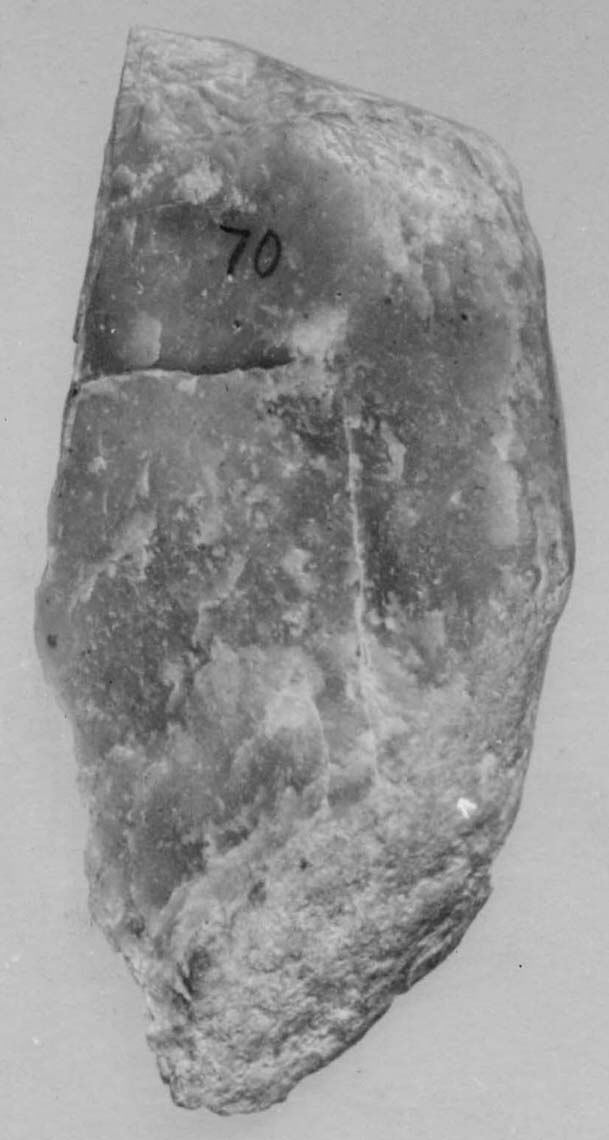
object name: fragment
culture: chinese or turkestani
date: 1902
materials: jade